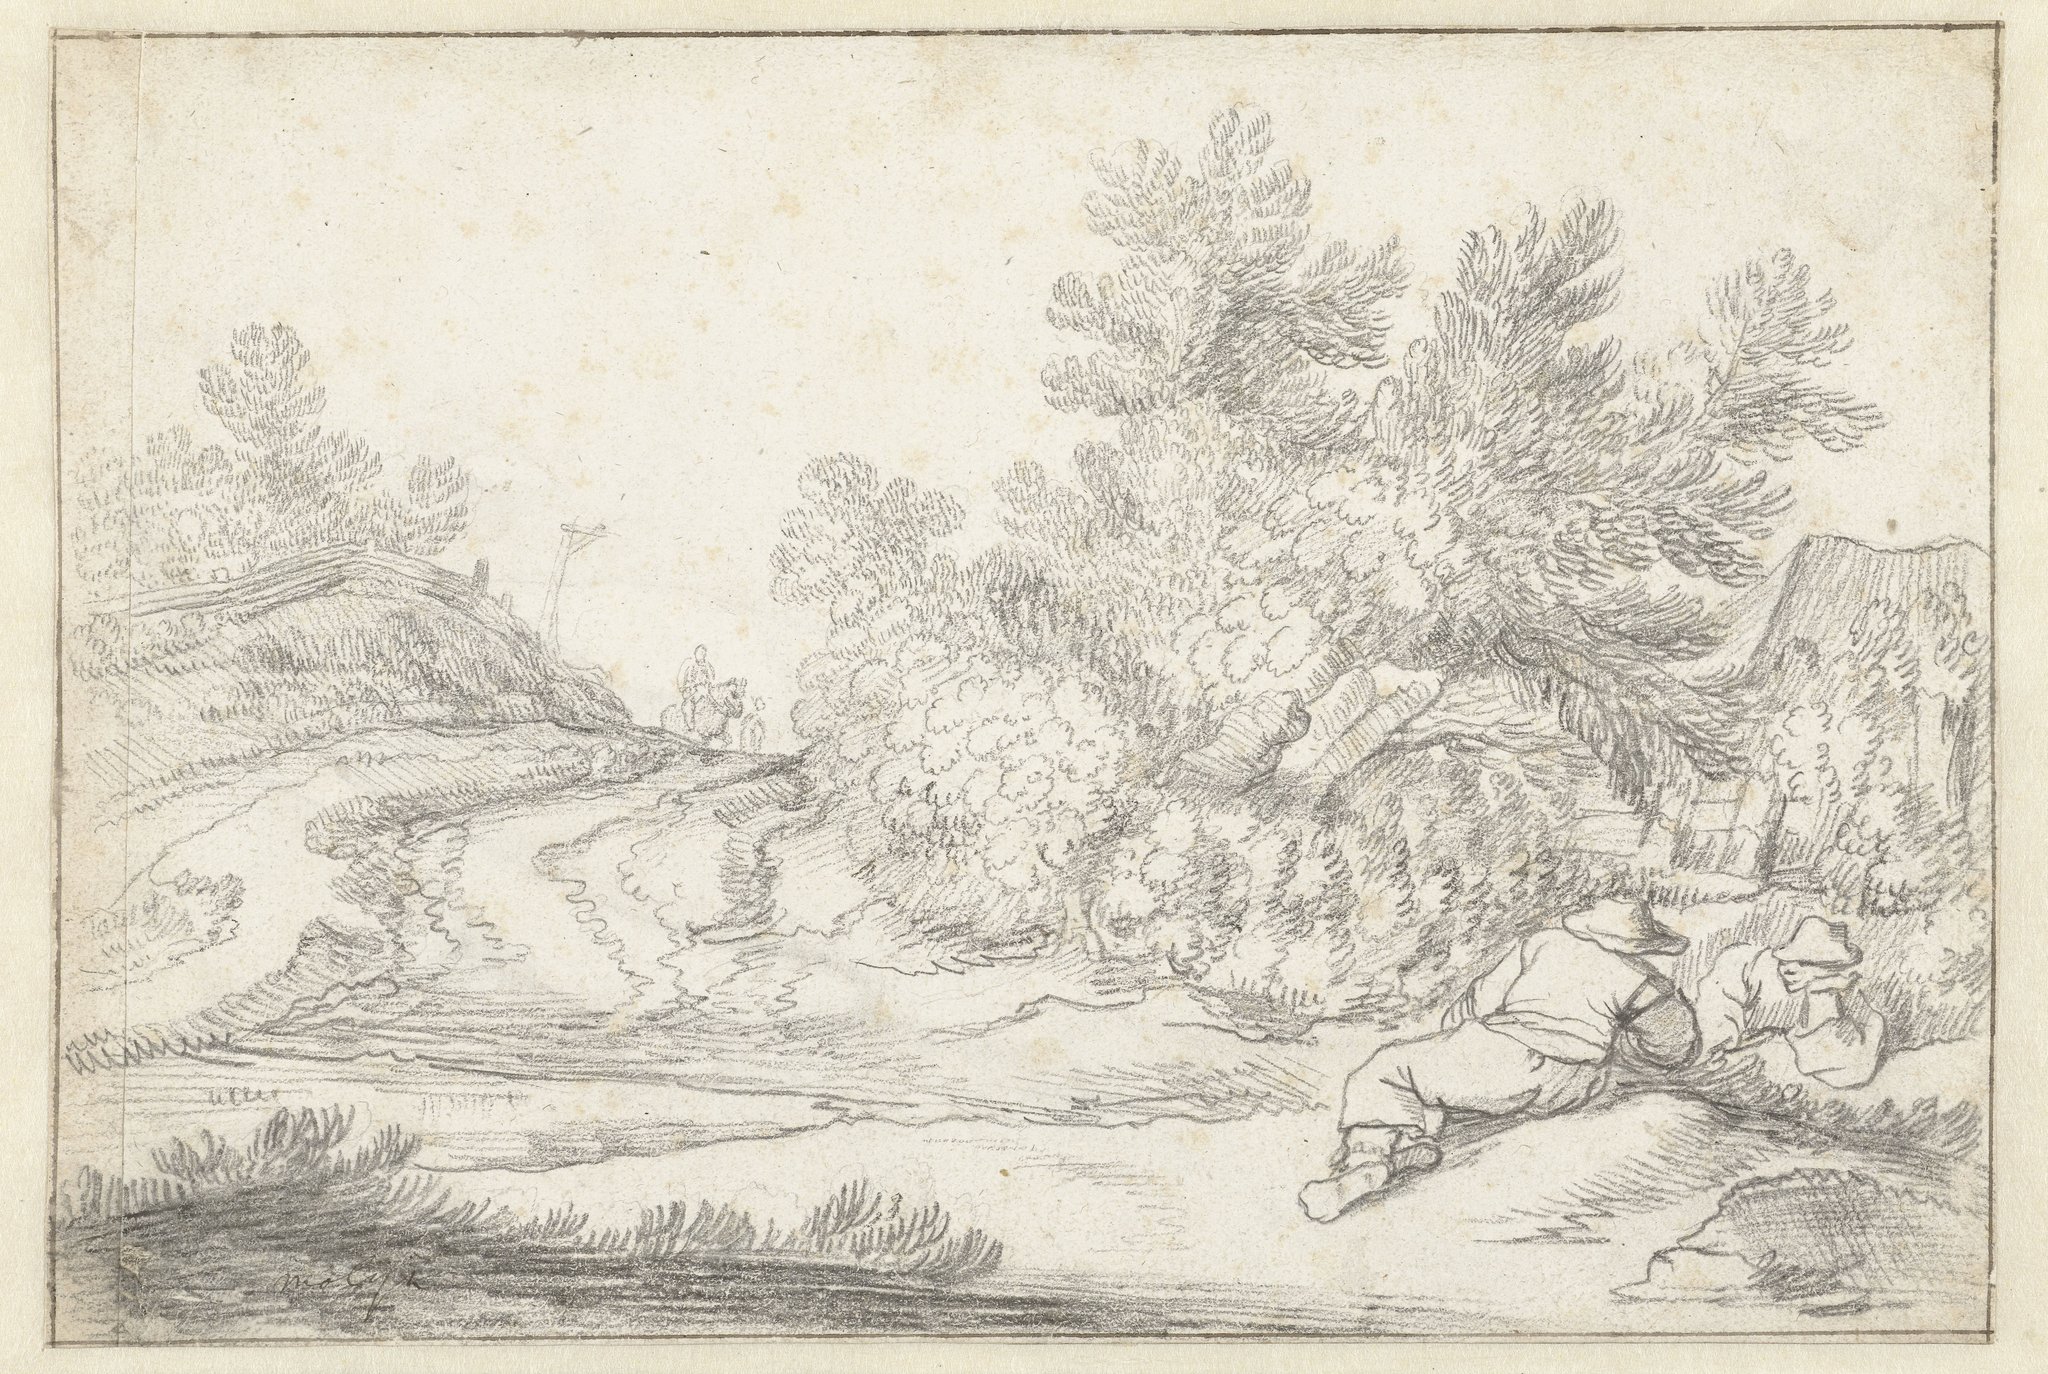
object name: drawing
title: Hellende landweg met een ruiter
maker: pieter de molijn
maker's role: draughtsman, painter, print maker, publisher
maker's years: 1595-1661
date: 1610-1660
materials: chalk, paper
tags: farm or solitary house in landscape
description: Hellende landweg met een ruiter; rechts liggen twee mannen die met elkaar in gesprek zijn.